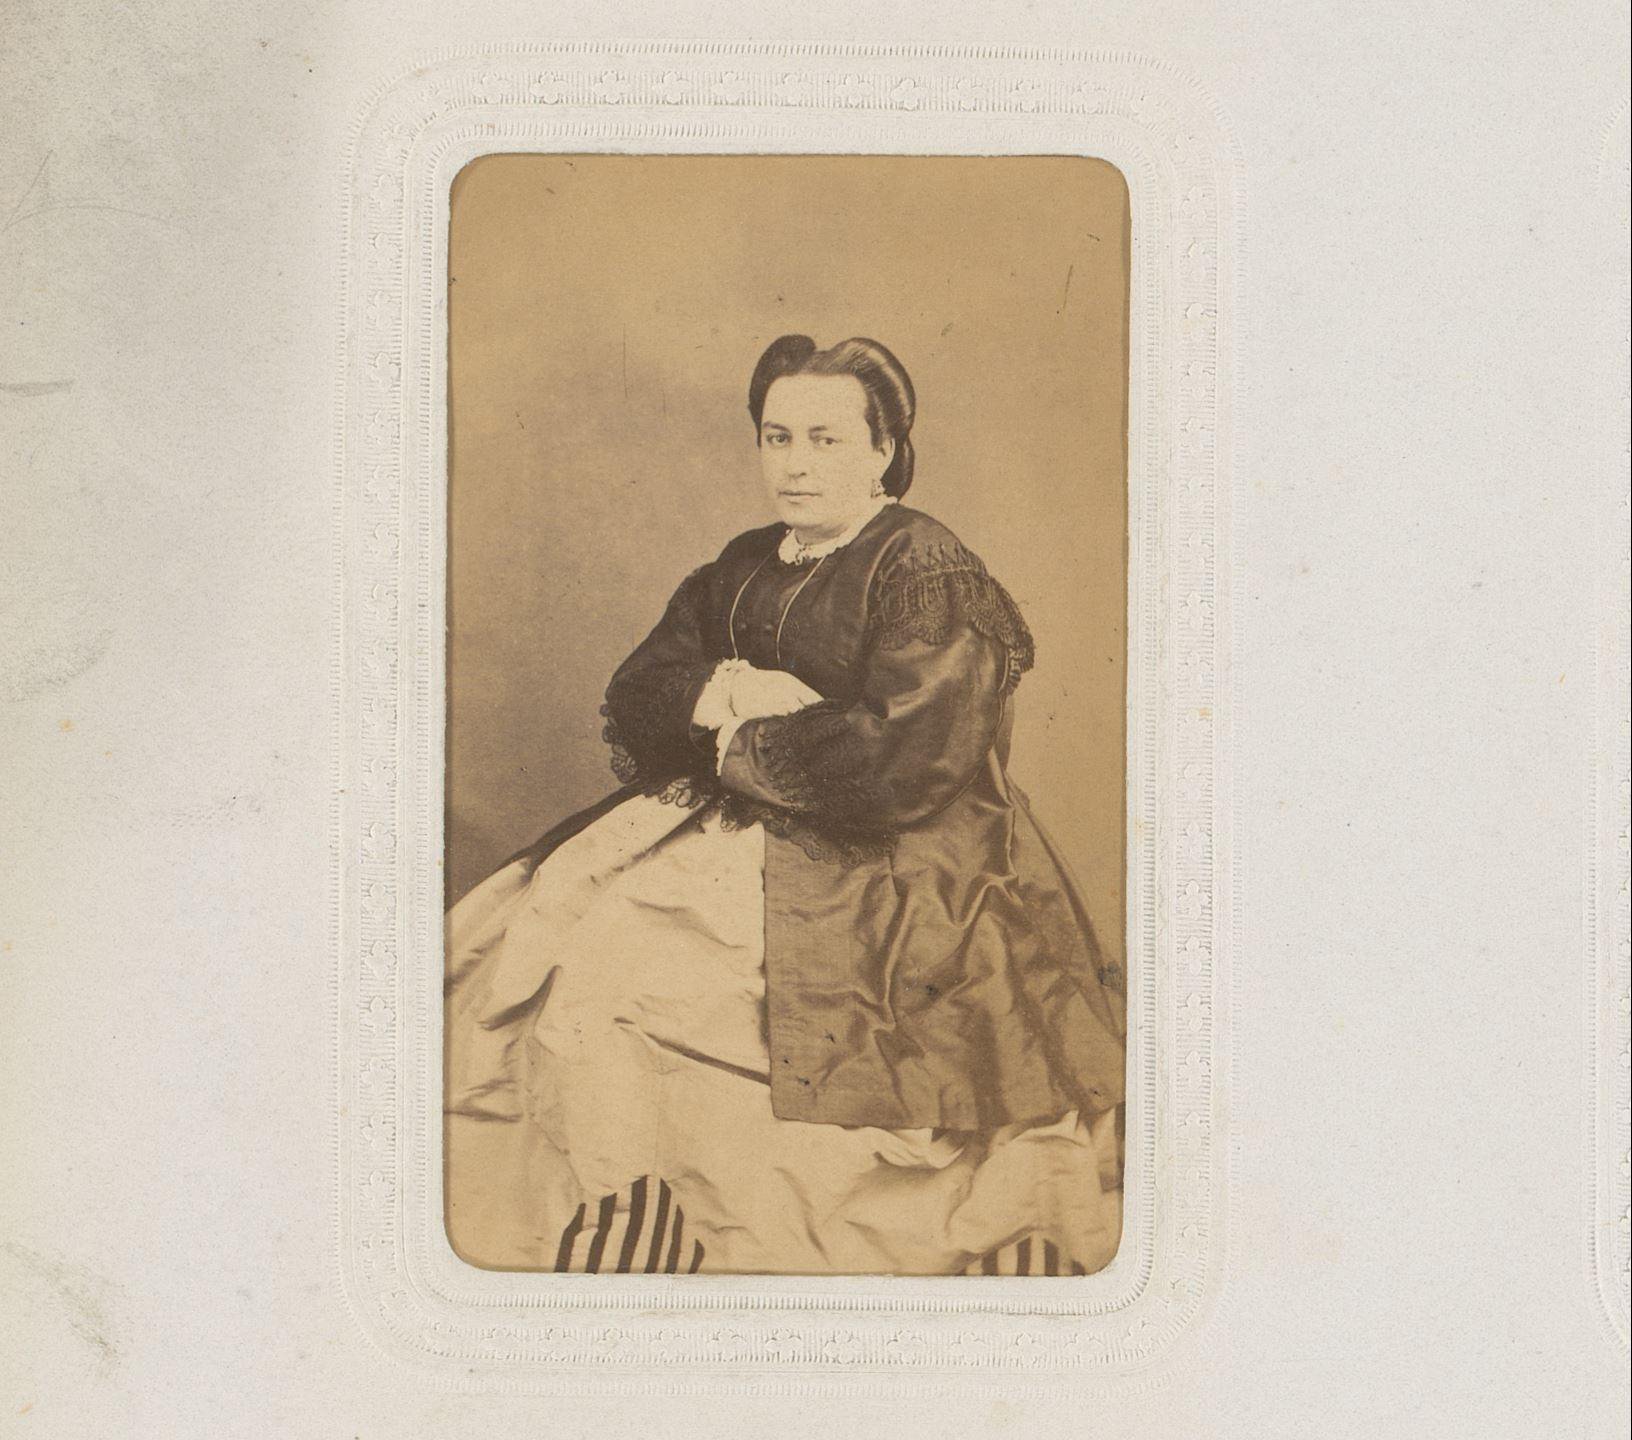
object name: photograph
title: Portret van een zittende vrouw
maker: rovira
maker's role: fotograaf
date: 1860-1890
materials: cardboard, photographic support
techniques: albumen print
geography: spain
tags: sitting figure - aa - female human figure, historical persons - bb - woman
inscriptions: inscription: ‘Rovira/ Fotógrafo/ Lorca’